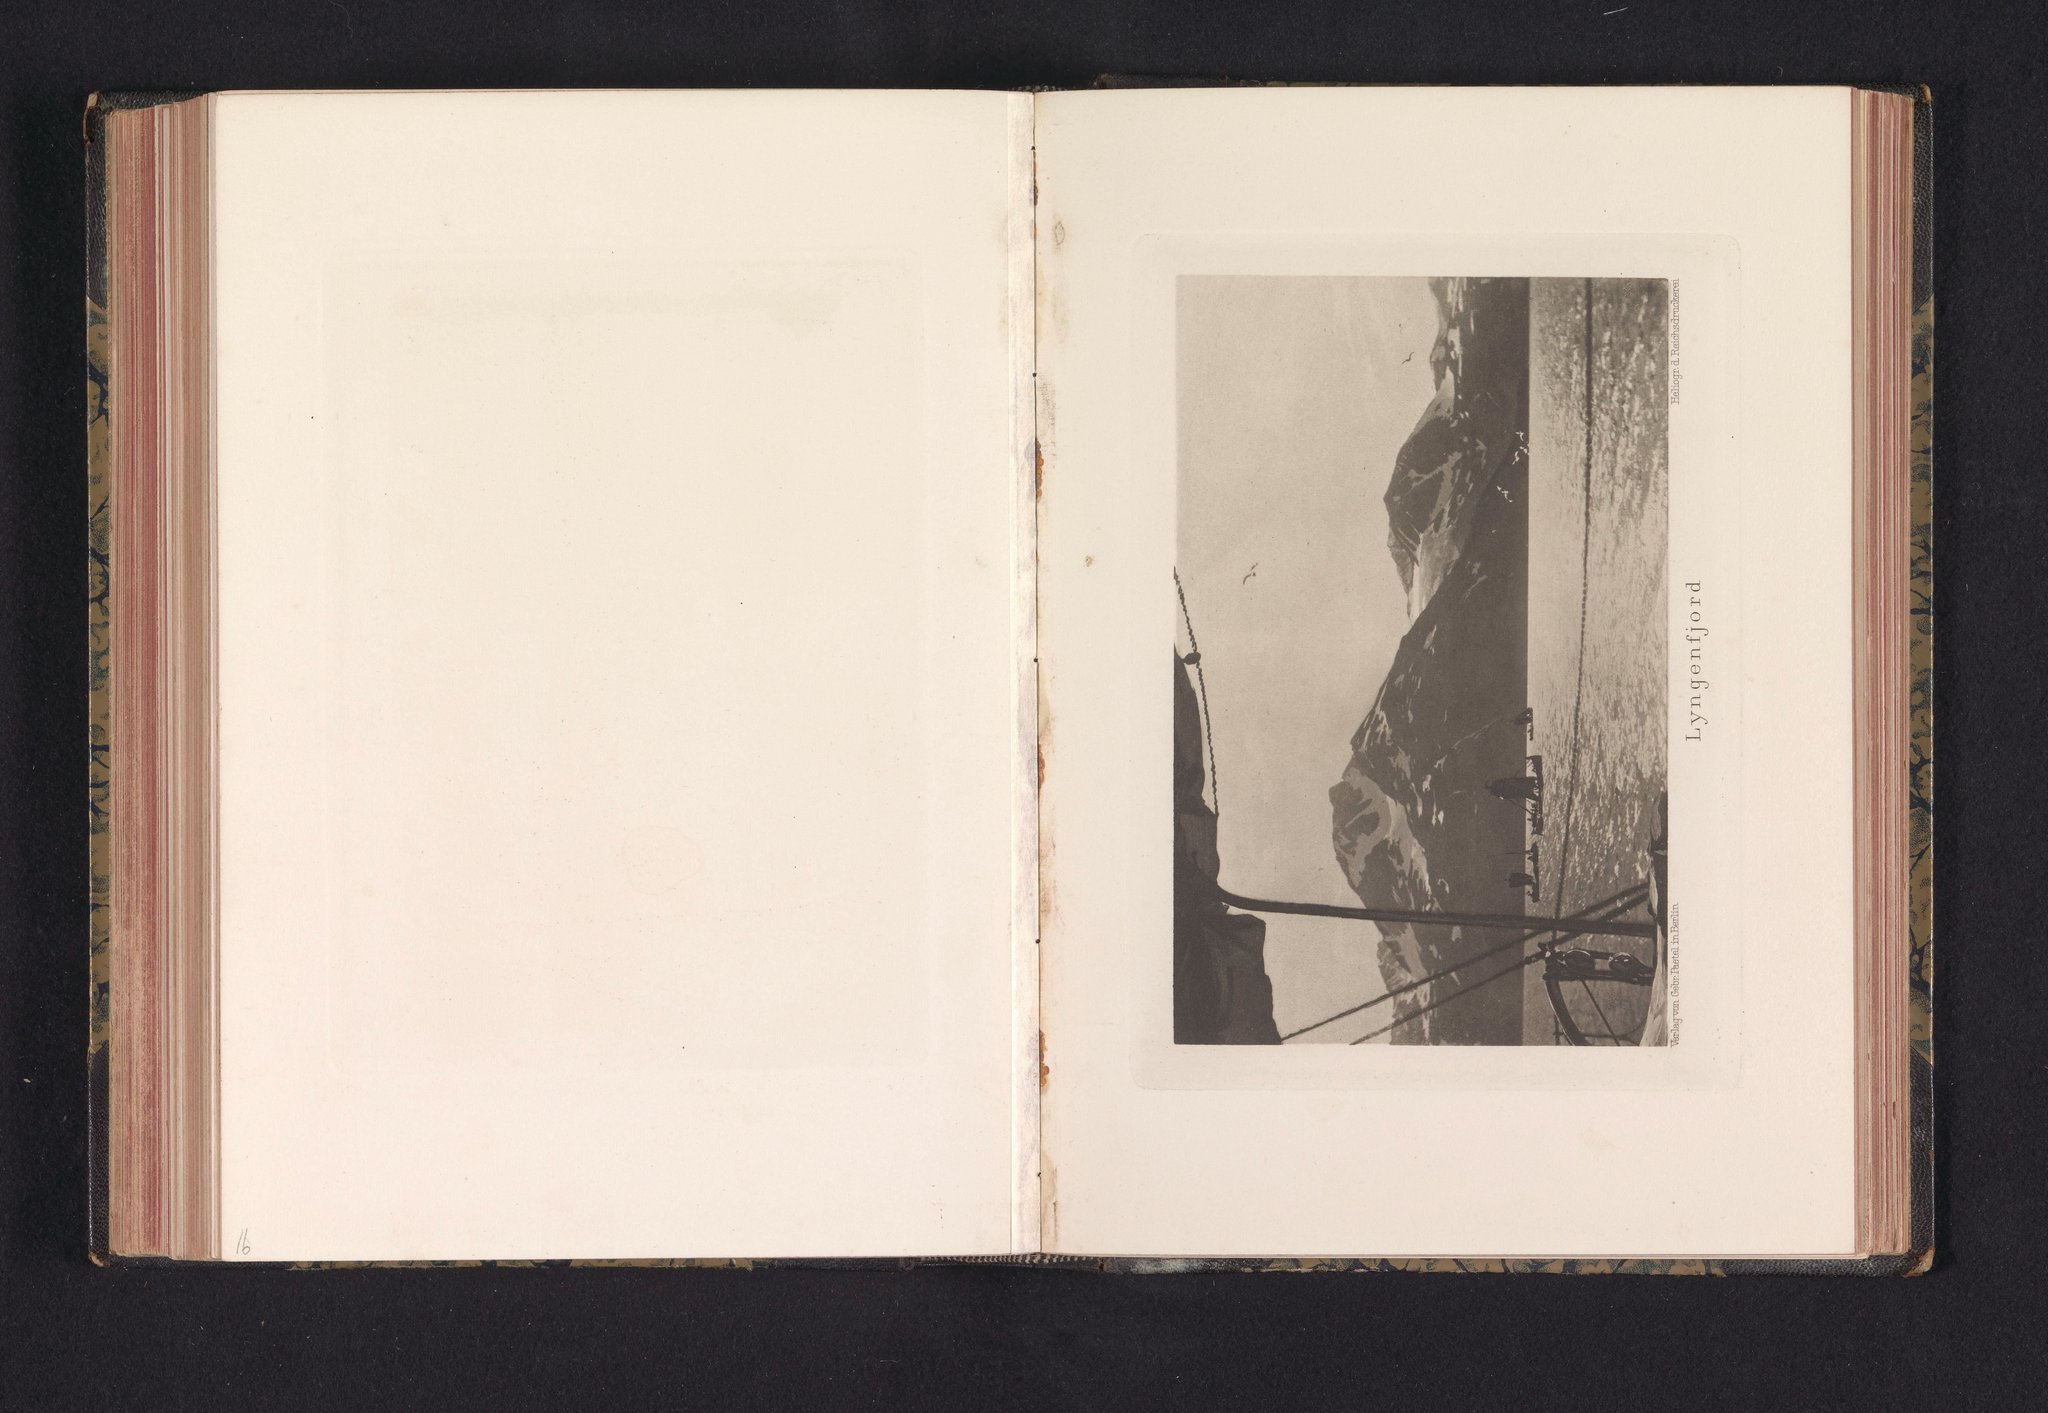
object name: page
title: Lyngenfjord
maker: paul güssfeldt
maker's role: alpinist, wiskundige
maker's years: 1840-1920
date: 1889-1892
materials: paper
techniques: photoaquatint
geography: berlin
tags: fjord, sea loch, rocky coast